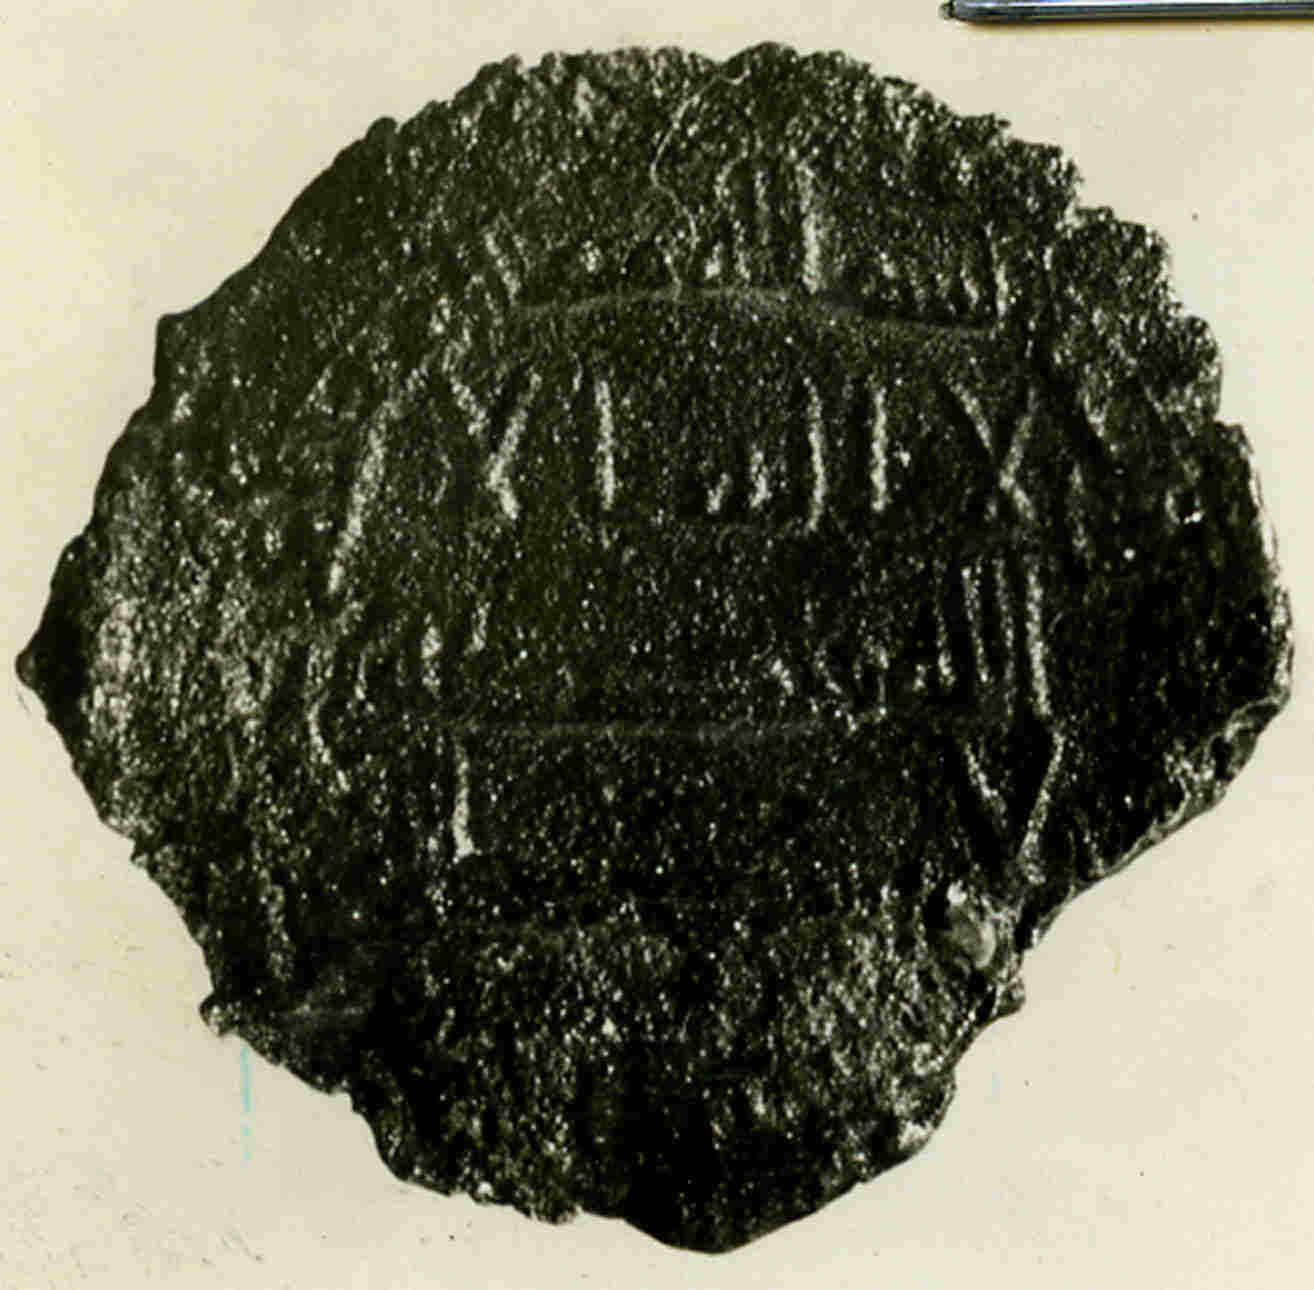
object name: coin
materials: copper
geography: al-muḥammadiyya